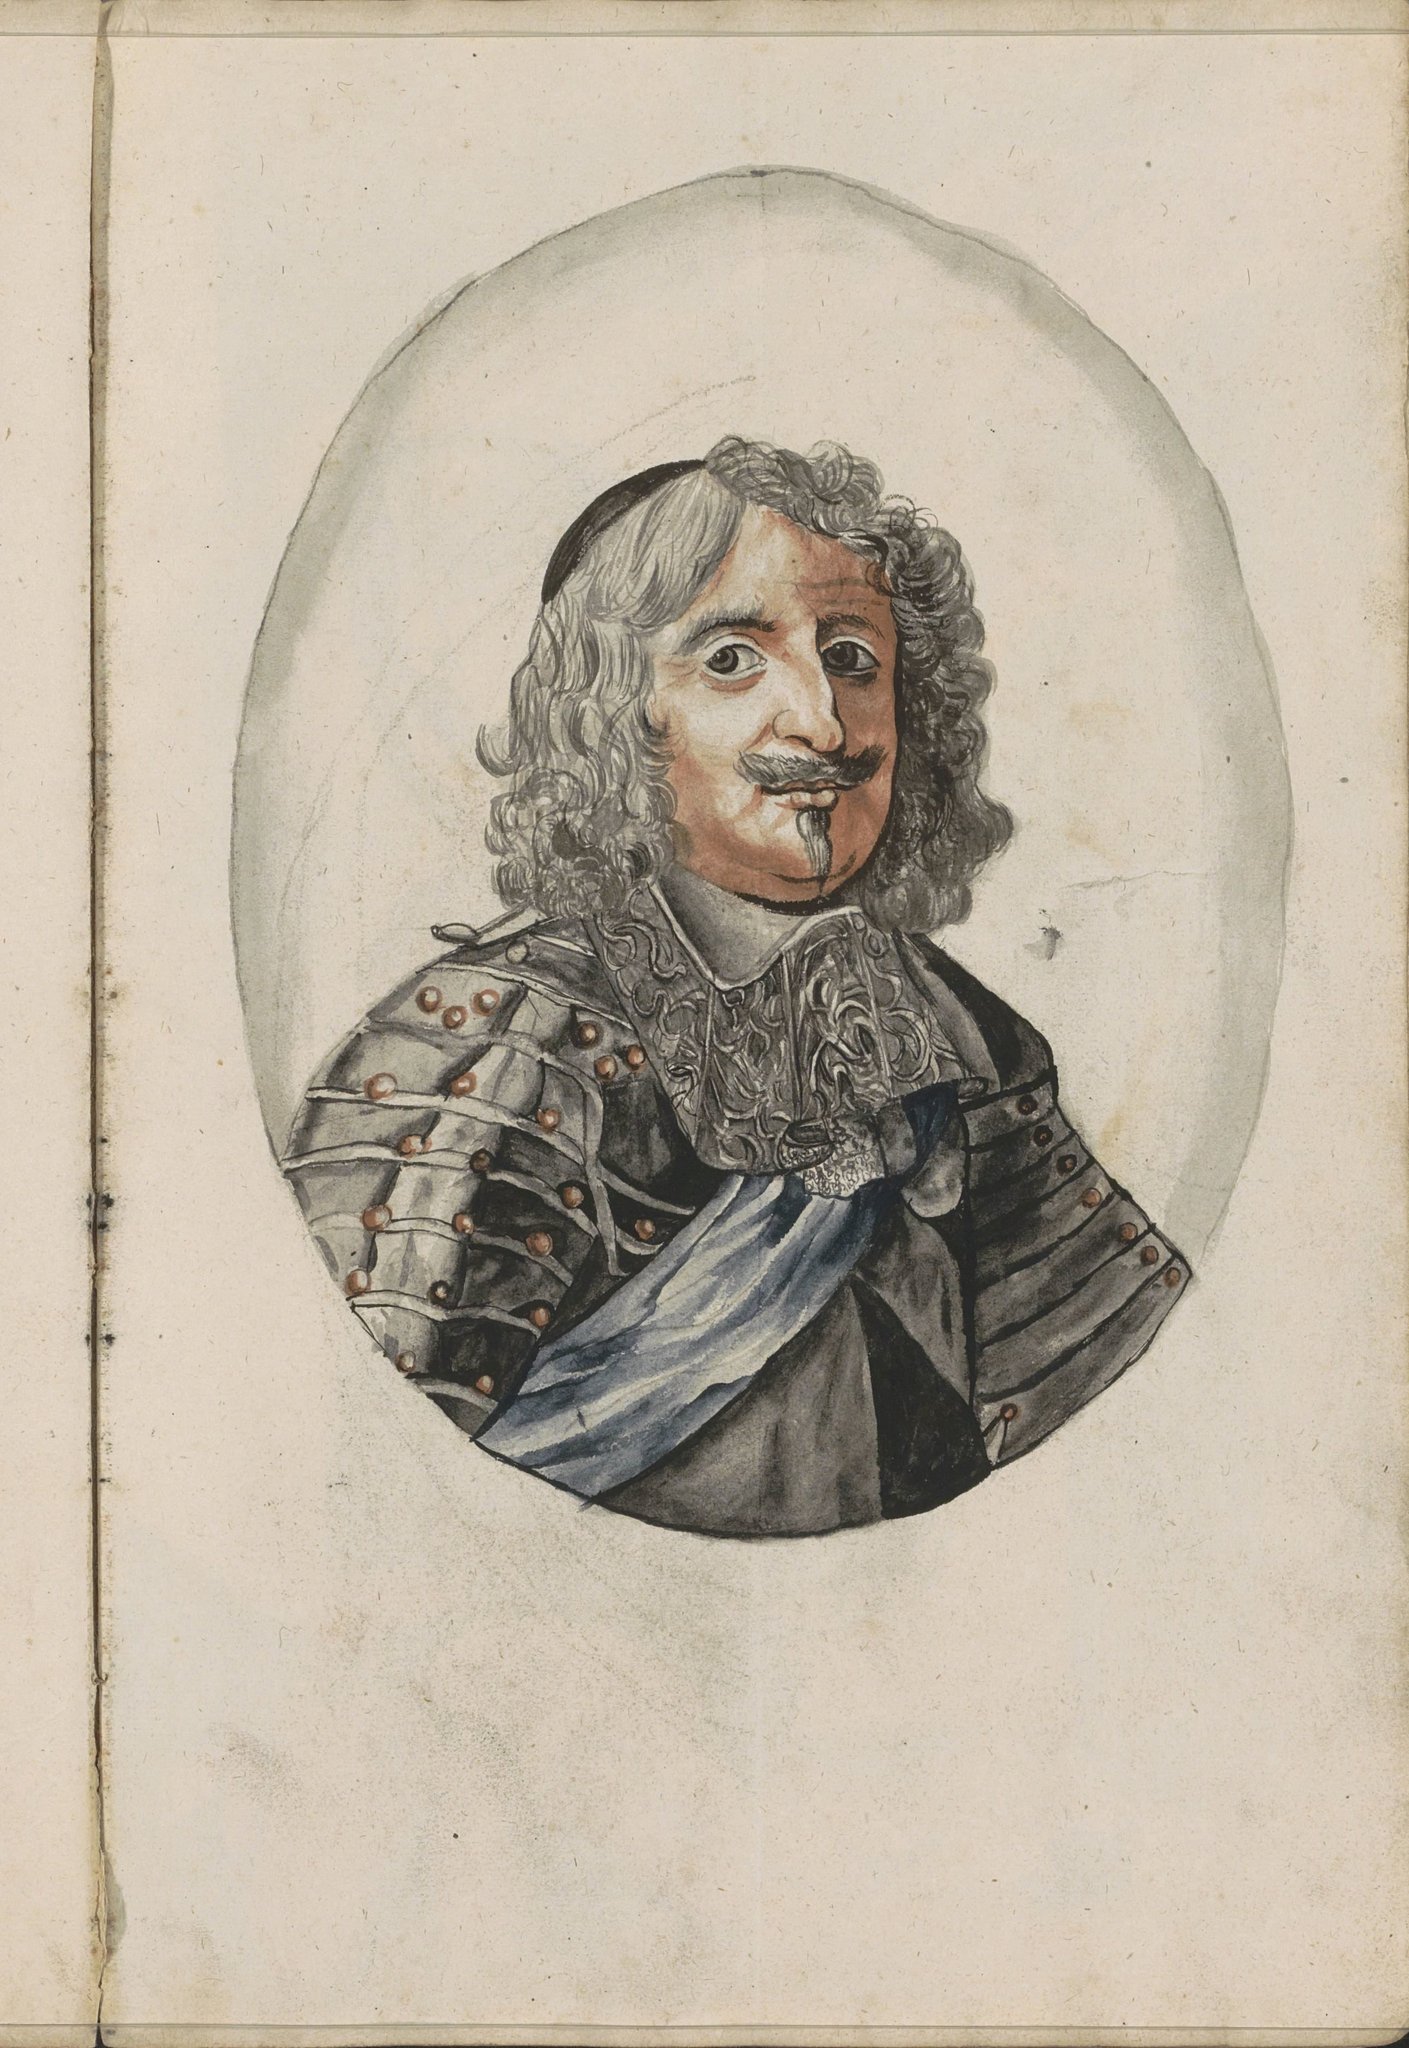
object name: sketchbook leaf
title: Portret van een man met een sjerp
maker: hendrick van beaumont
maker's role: draughtsman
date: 1696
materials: ink, paper, watercolor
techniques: brush, pen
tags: anonymous historical person portrayed alone (+ (full) bust portrait)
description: Blad 74 recto uit een schetsboek met 91 bladen.